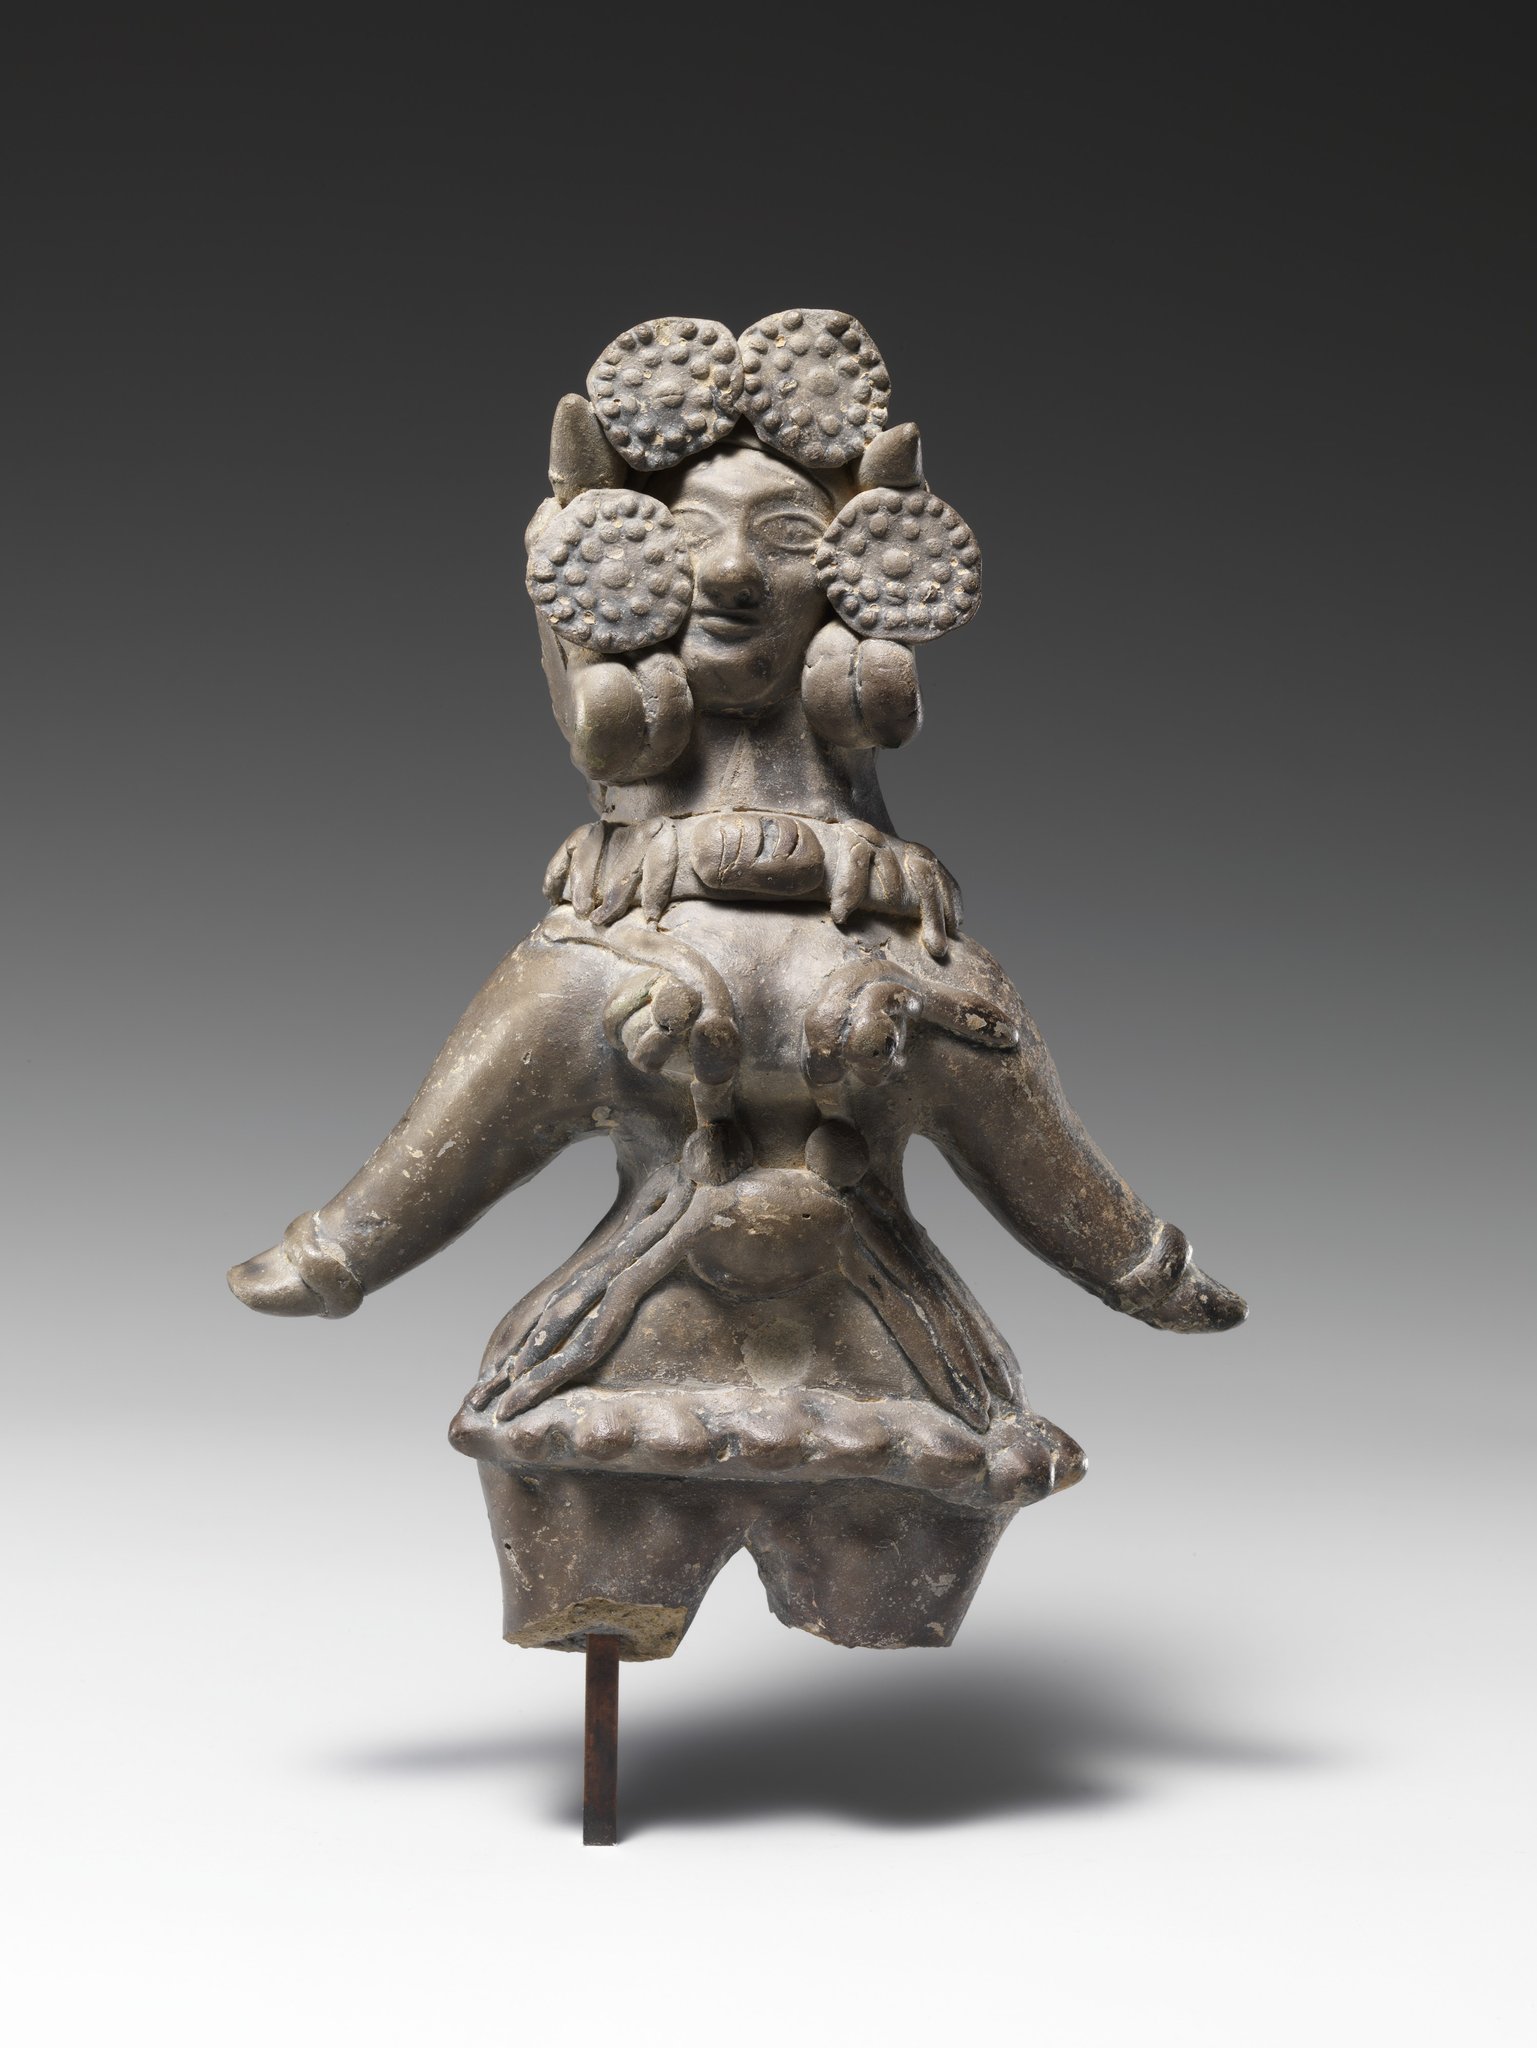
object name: figure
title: Standing Female Deity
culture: indian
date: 300-101 BCE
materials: patina, terracotta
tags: maurya,mauryan